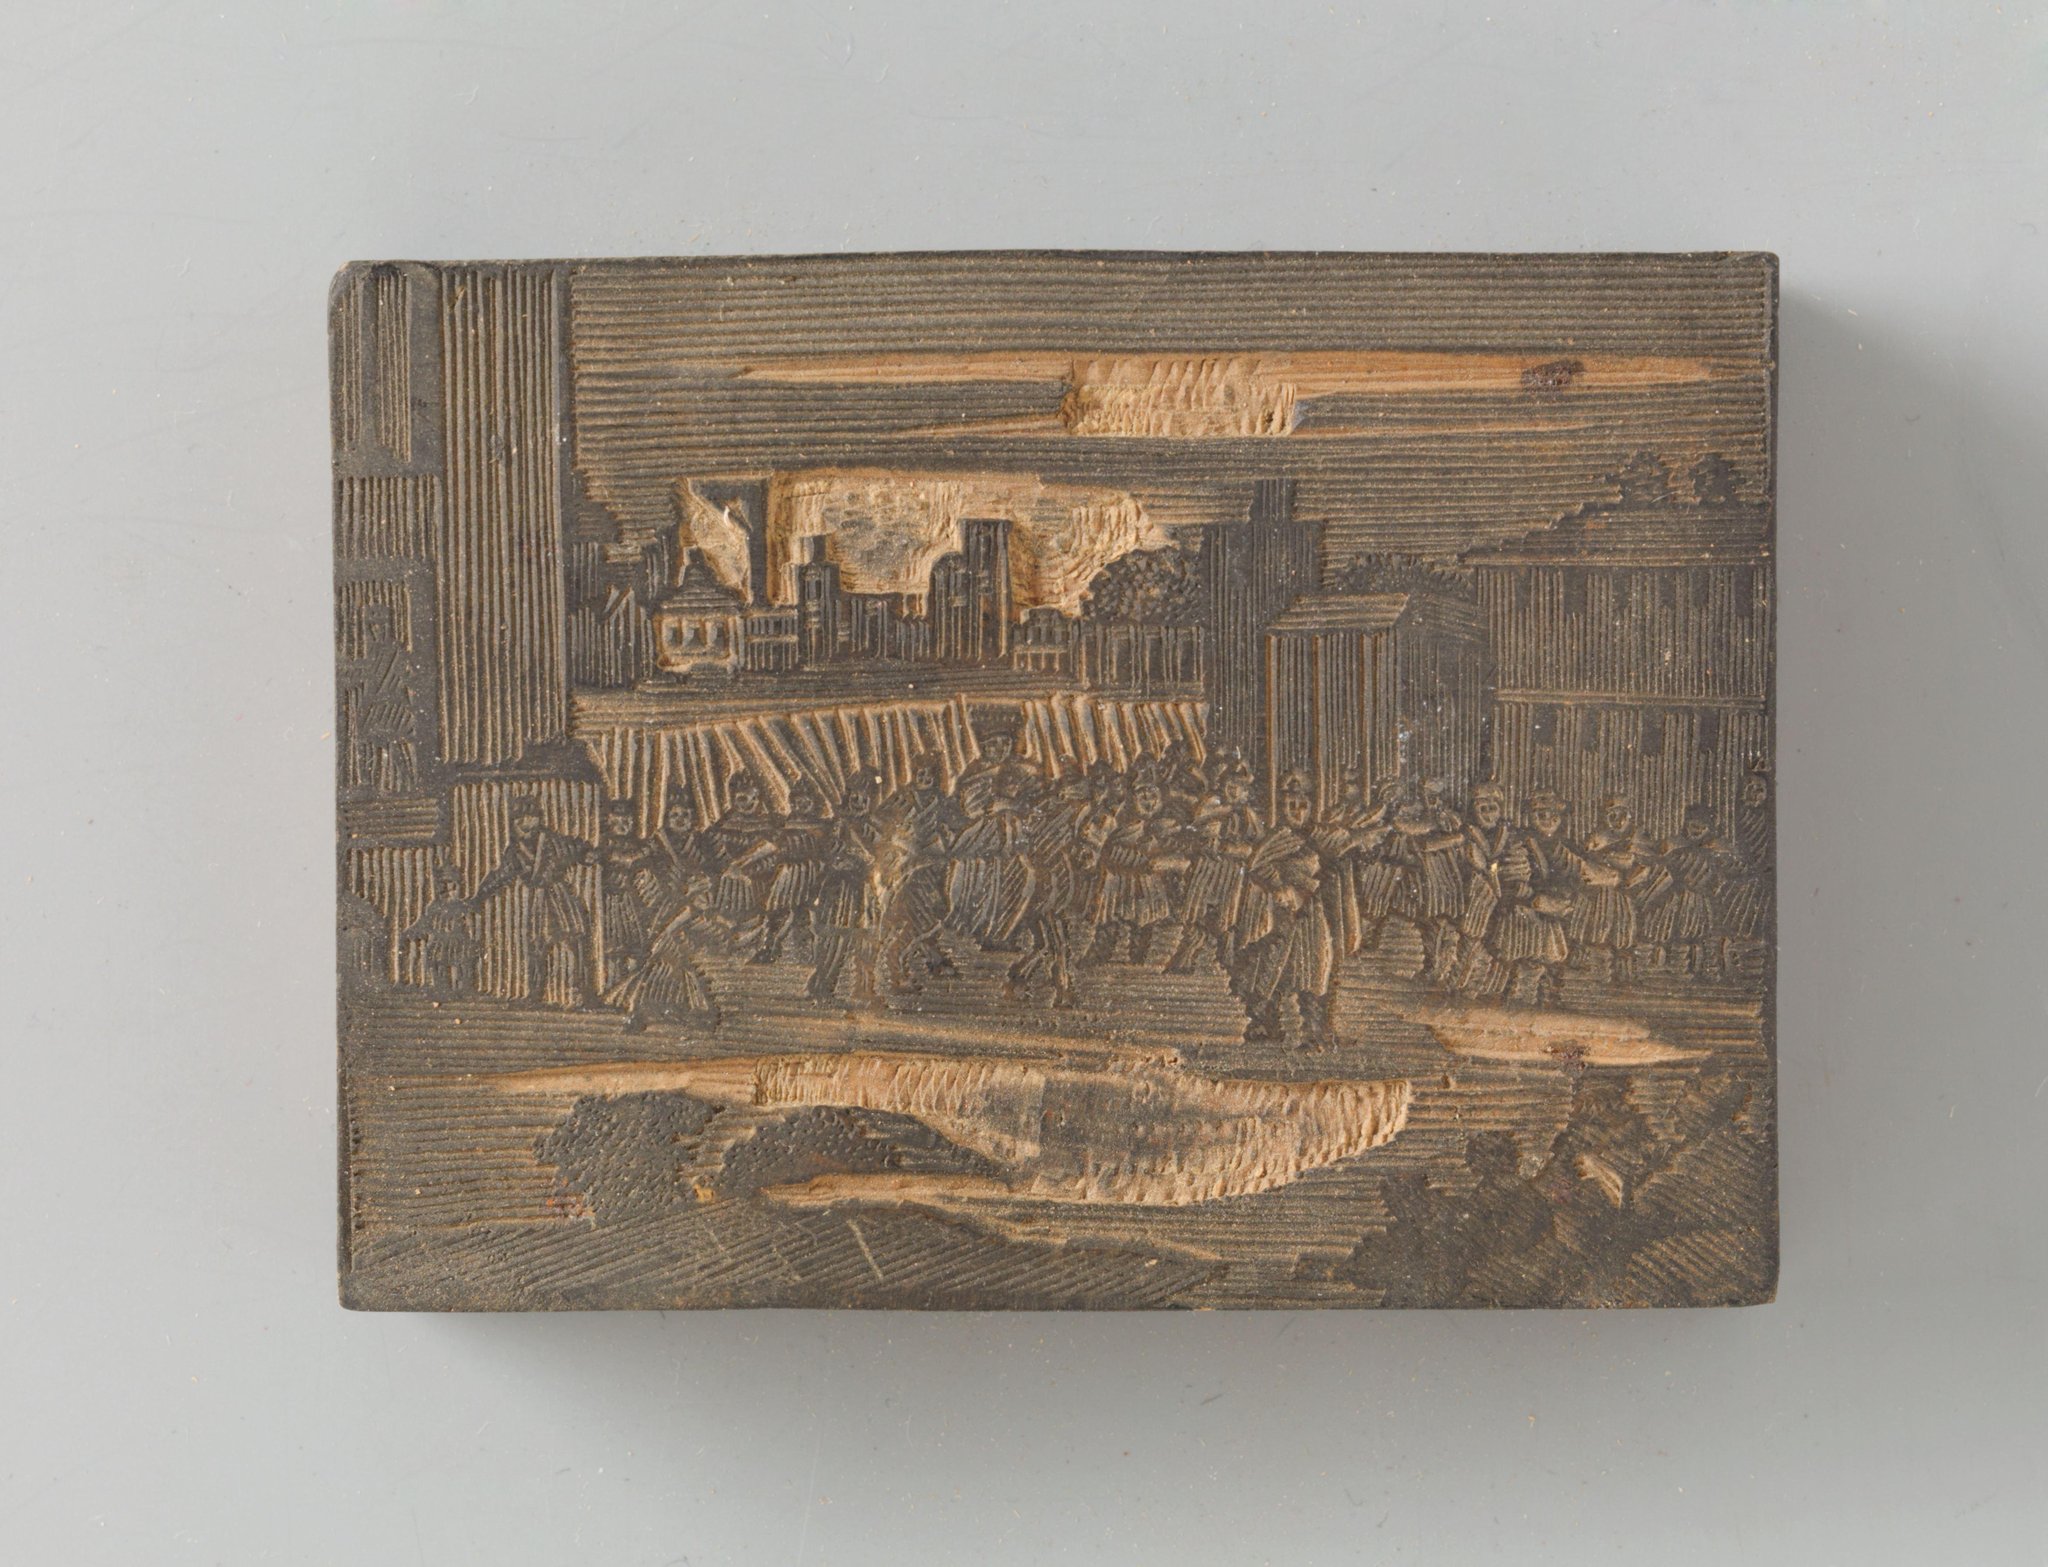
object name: wood block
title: Bijbel-illustraties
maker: Anonymous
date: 1550-1699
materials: wood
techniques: woodcut